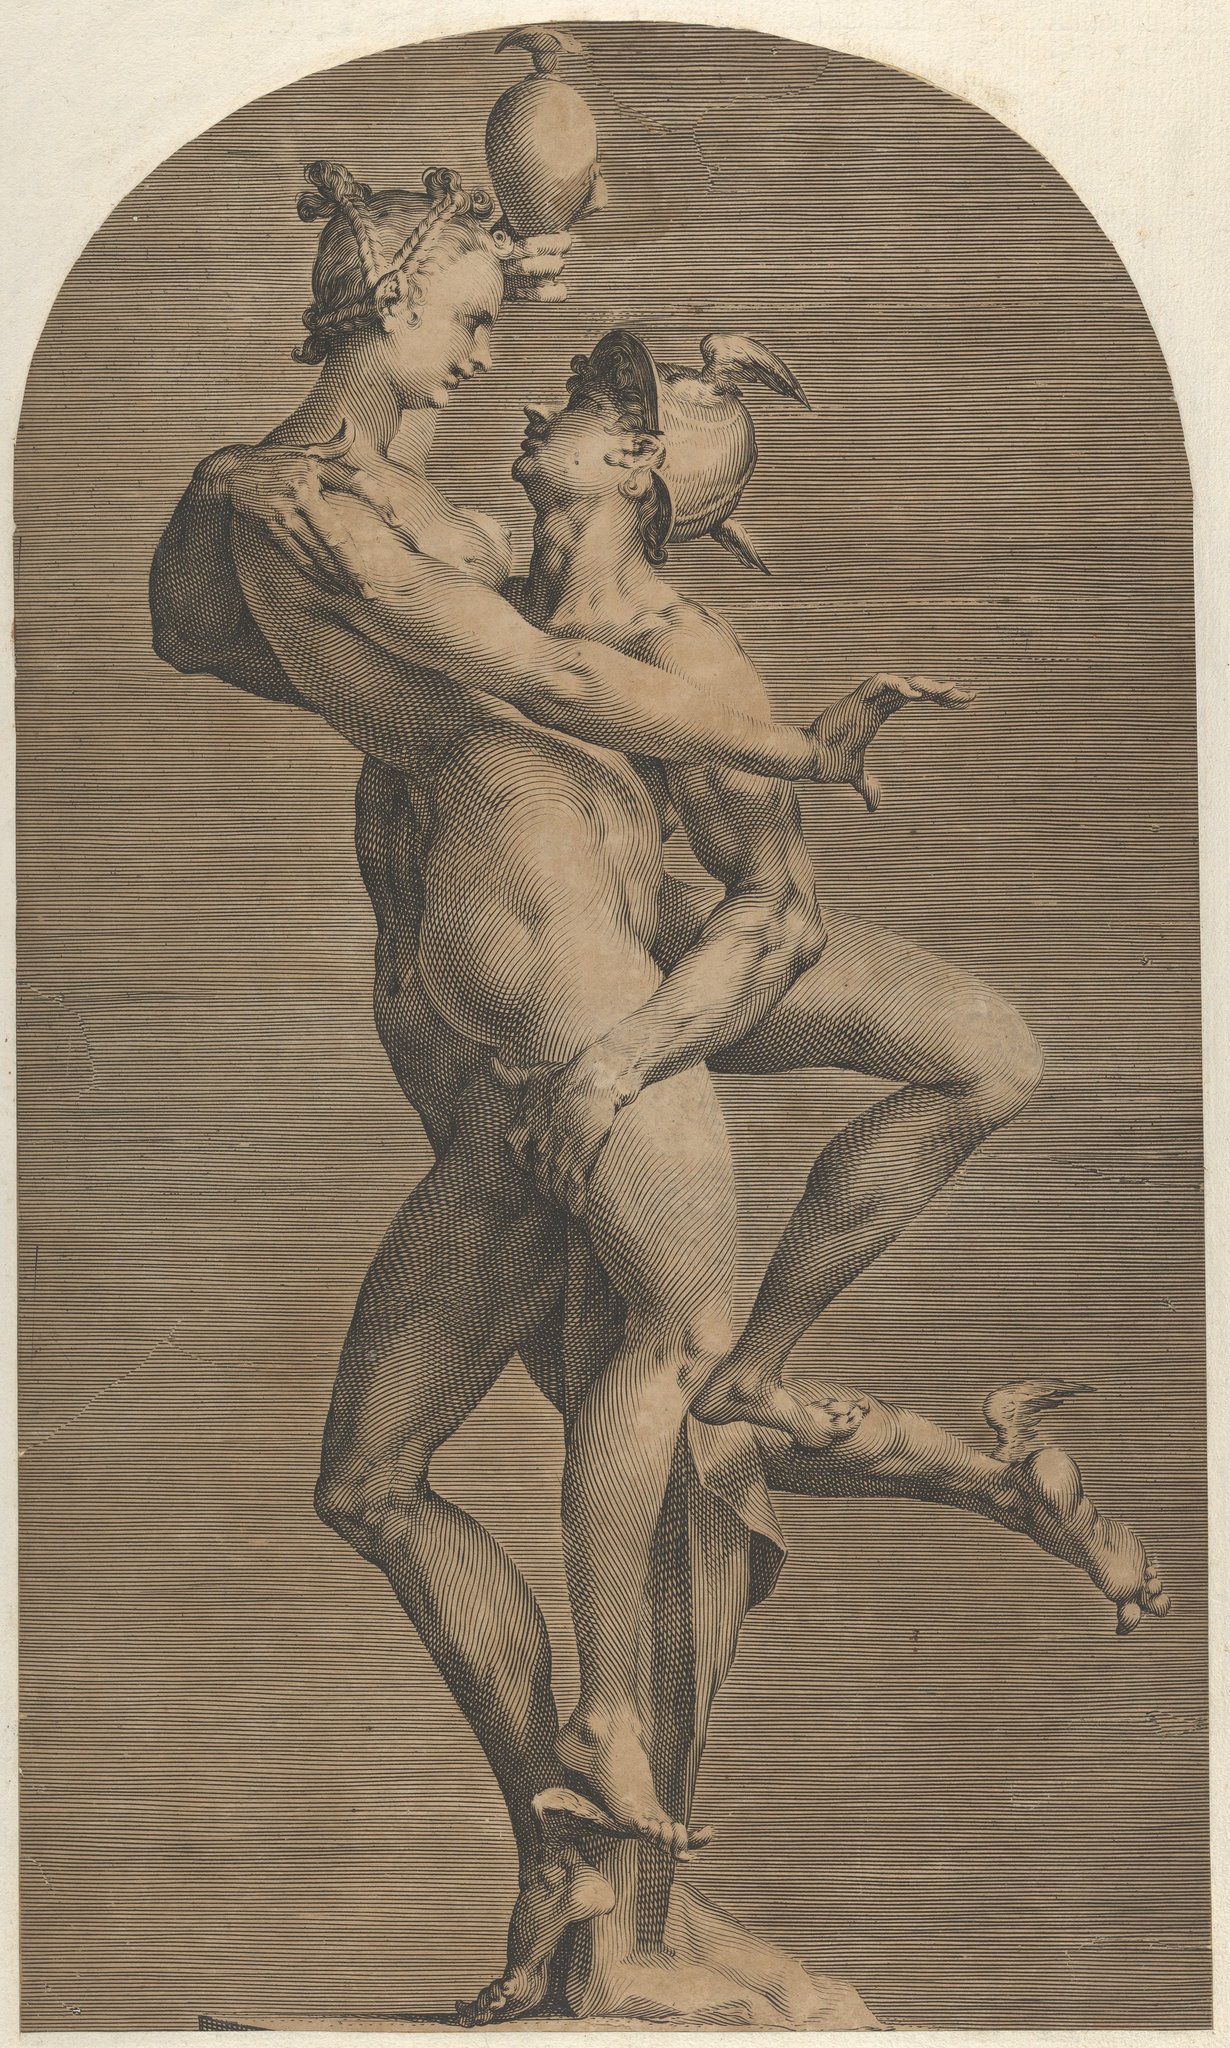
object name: print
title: Mercury Abducting Psyche (lateral view Psyche's side), from a set of three views of the sculpture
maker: jan muller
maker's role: artist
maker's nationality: netherlandish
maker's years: 1571-1628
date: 1593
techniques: engraving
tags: psyche,mercury